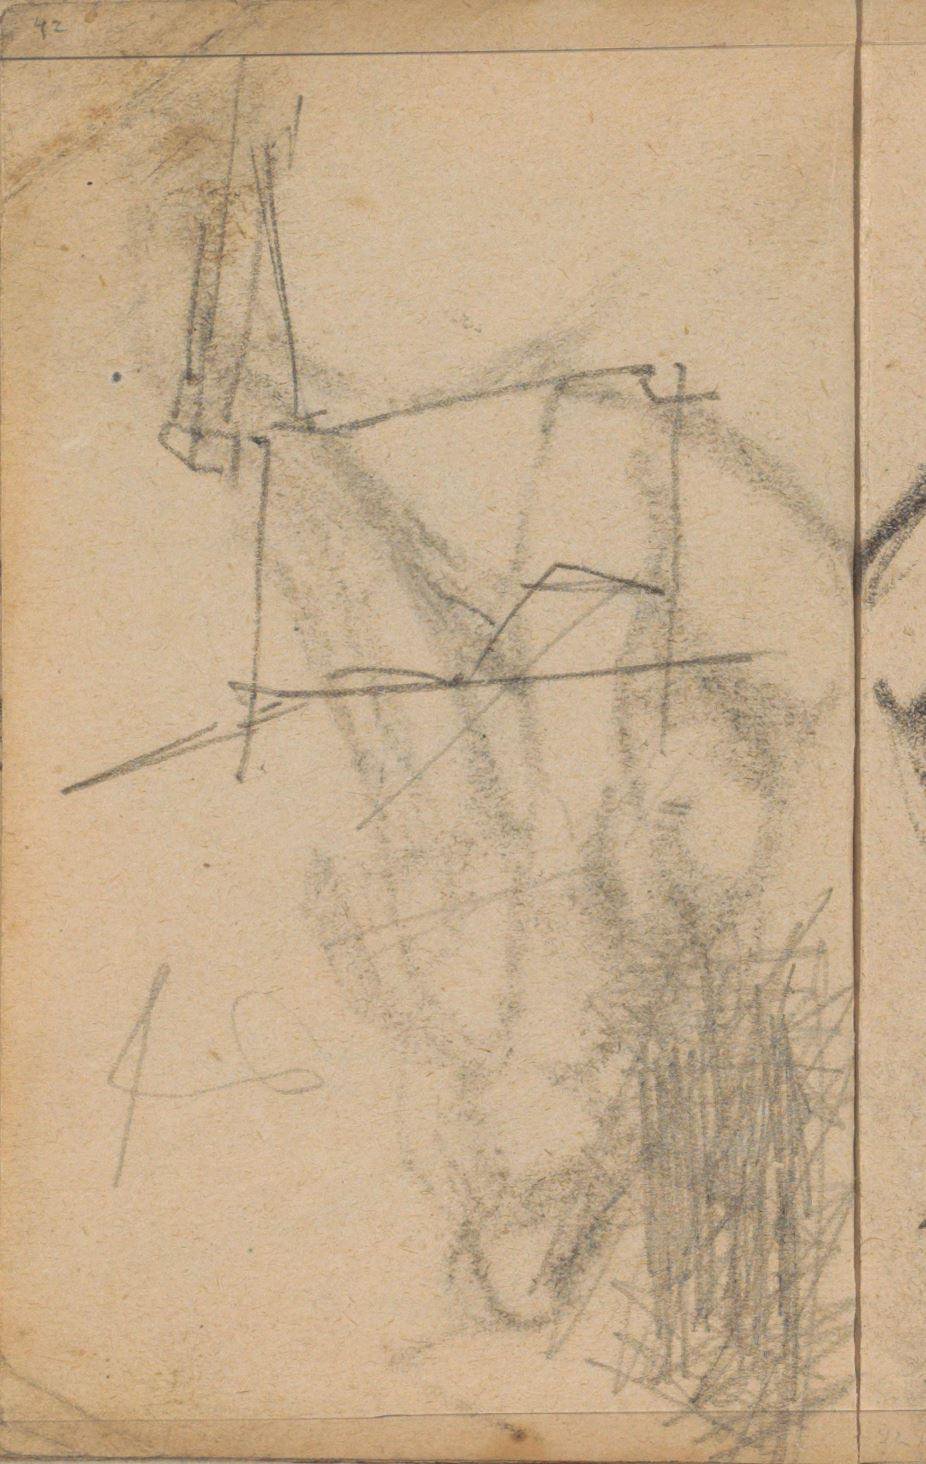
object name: sketchbook leaf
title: Studie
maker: george hendrik breitner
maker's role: draughtsman, painter, print maker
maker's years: 1857-1923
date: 1881-1883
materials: chalk, paper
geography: south holland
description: Studie. Pagina 42 uit een schetsboek met 43 bladen.